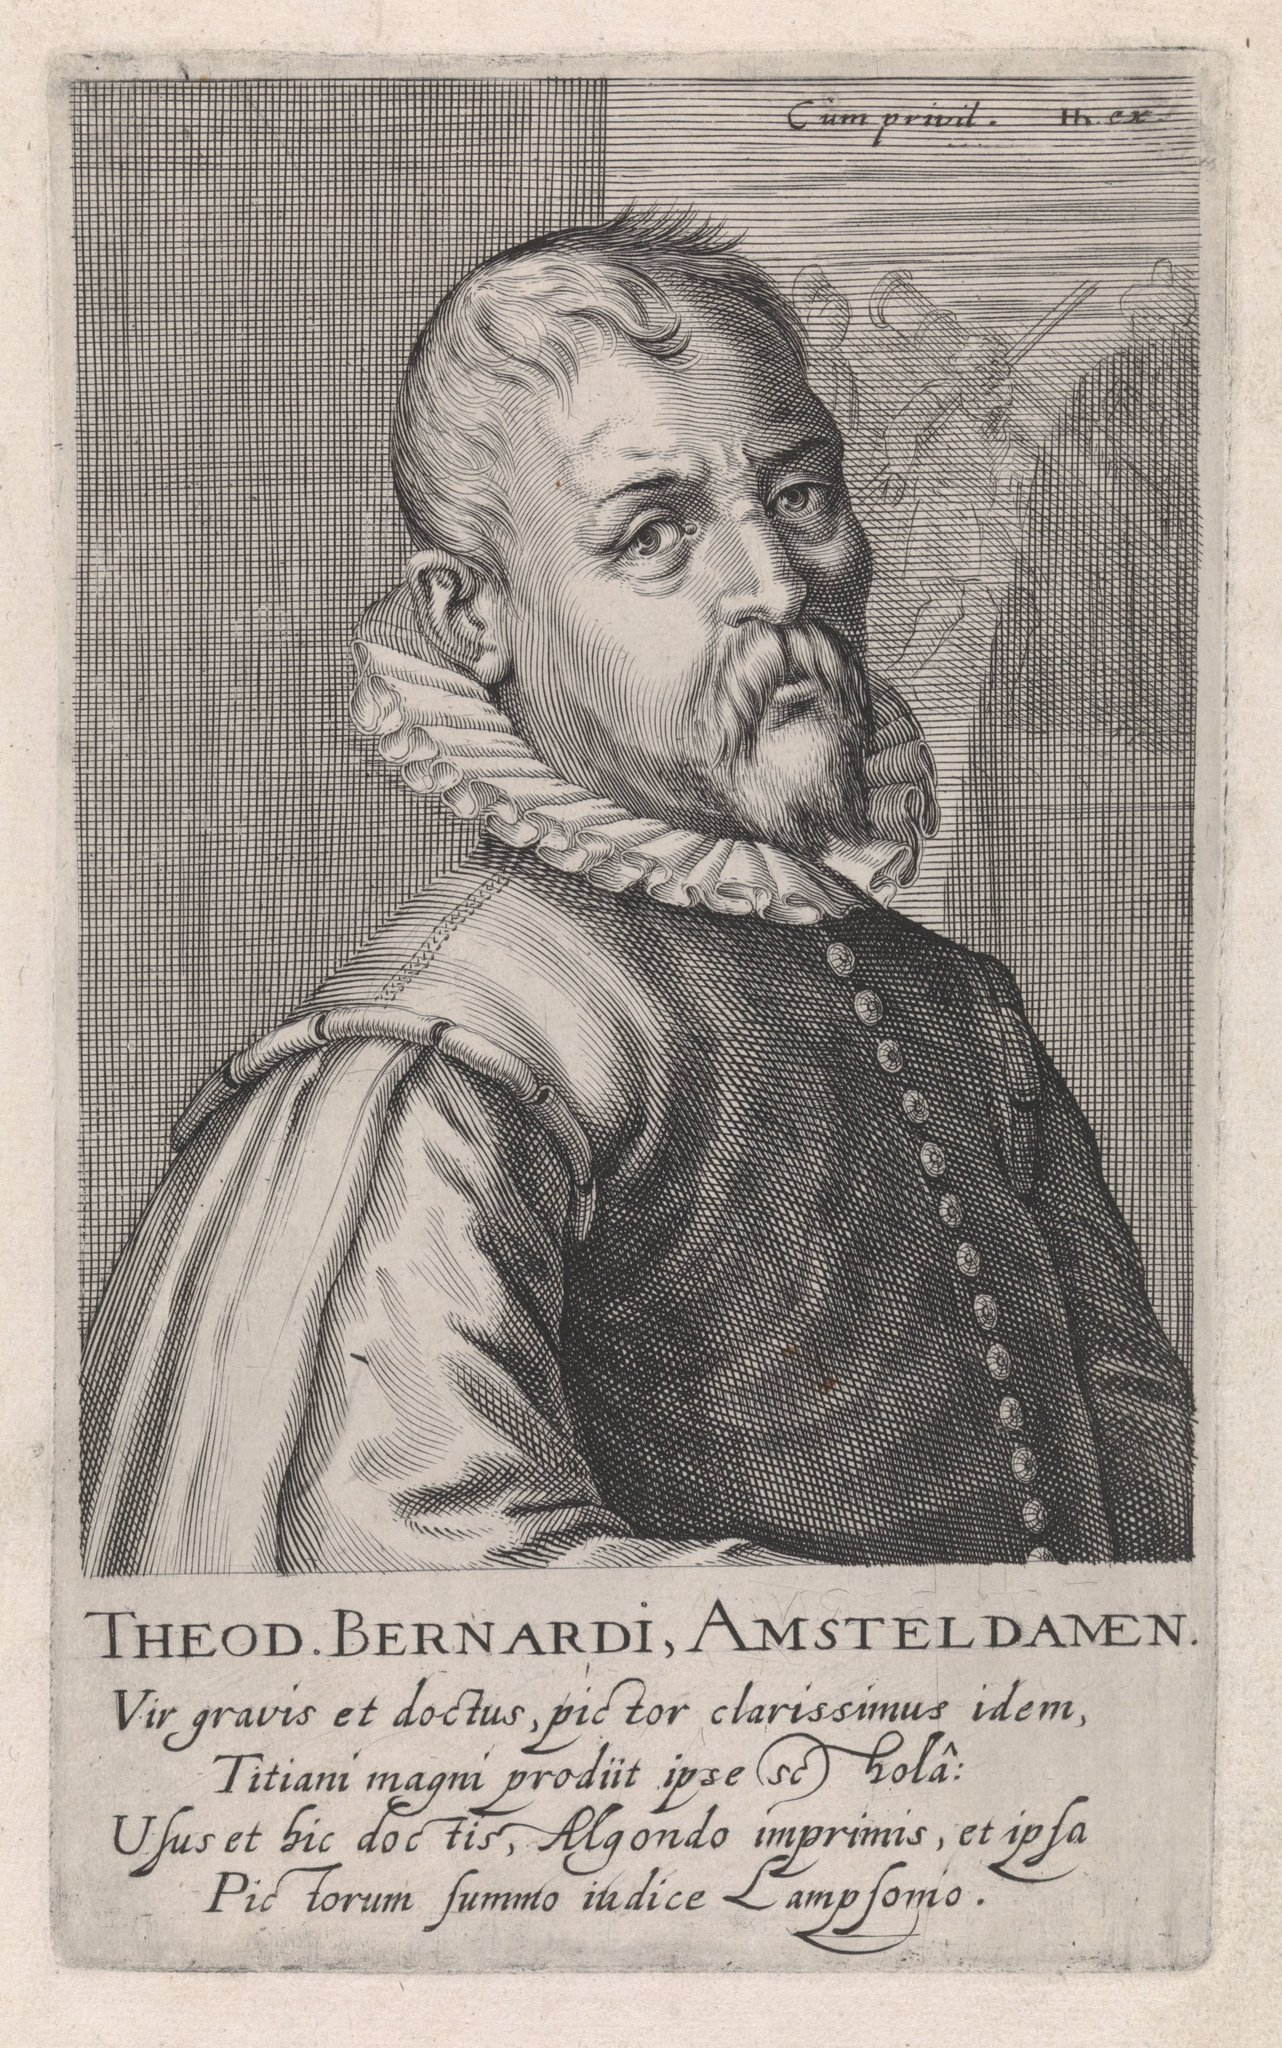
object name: print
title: Theod. Bernardi, Amsteldamen.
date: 1610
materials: paper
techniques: engraving, etching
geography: the hague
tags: dirck barendsz., portrait, self-portrait of painter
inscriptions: collector's mark: Lugt 964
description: Buste naar rechts van Dirck Barendsz.. Onder het portret zijn naam en vier regels in het Latijn. Prent uit deel 2 van de serie Pictorum Aliquot Celebrium Praecipuae Germaniae Inferioris Effigies. Serie van 72 kunstenaarsportretten vervaardigd door Hendrick Hondius I, Simon Frisius, Andries Jacobsz. Stock en Robert de Baudous.